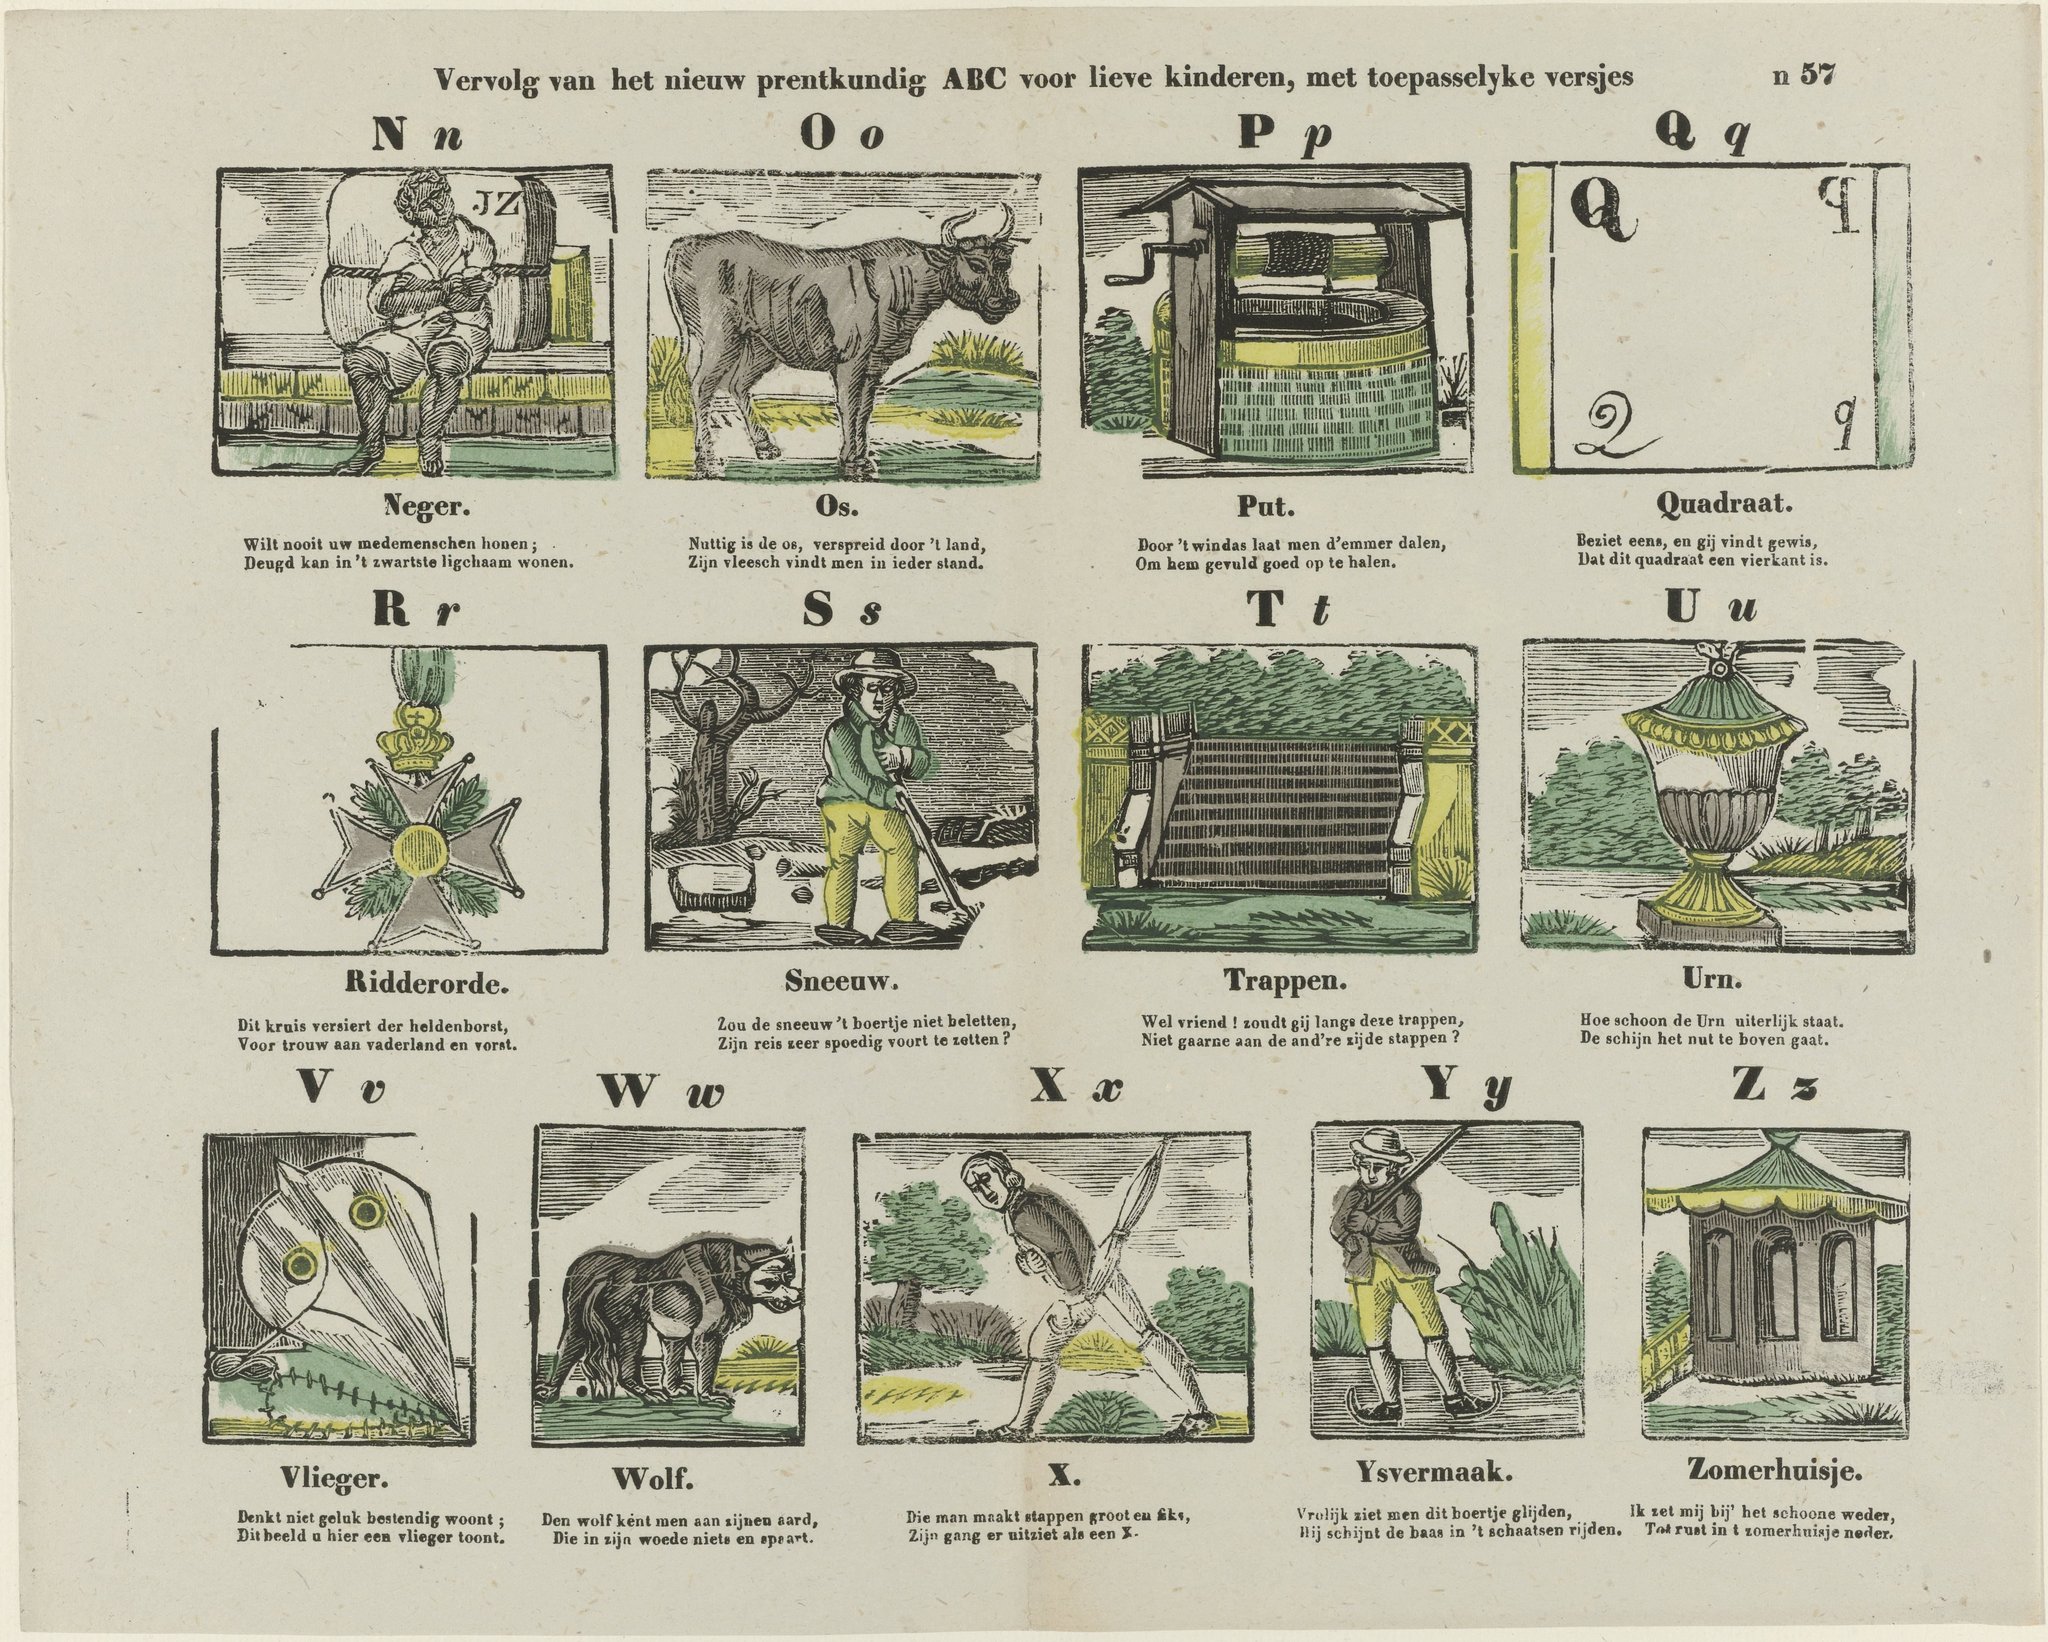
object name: popular print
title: Vervolg van het nieuw prentkundig ABC voor lieve kinderen, met toepasselyke versjes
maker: monogrammist jz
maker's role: print maker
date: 1856-1900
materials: paper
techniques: colour, letterpress printing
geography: netherlands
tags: letters, alphabet, script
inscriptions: collector's mark: Lugt 2760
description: Blad met 13 voorstellingen van de letters van het alfabet (N-Z) geïllustreerd met voorwerpen, dieren, gebouwen en figuren waarvan de woorden met de betreffende letter beginnen. Onder elke voorstelling een onderschrift. Genummerd rechtsboven: n 57.